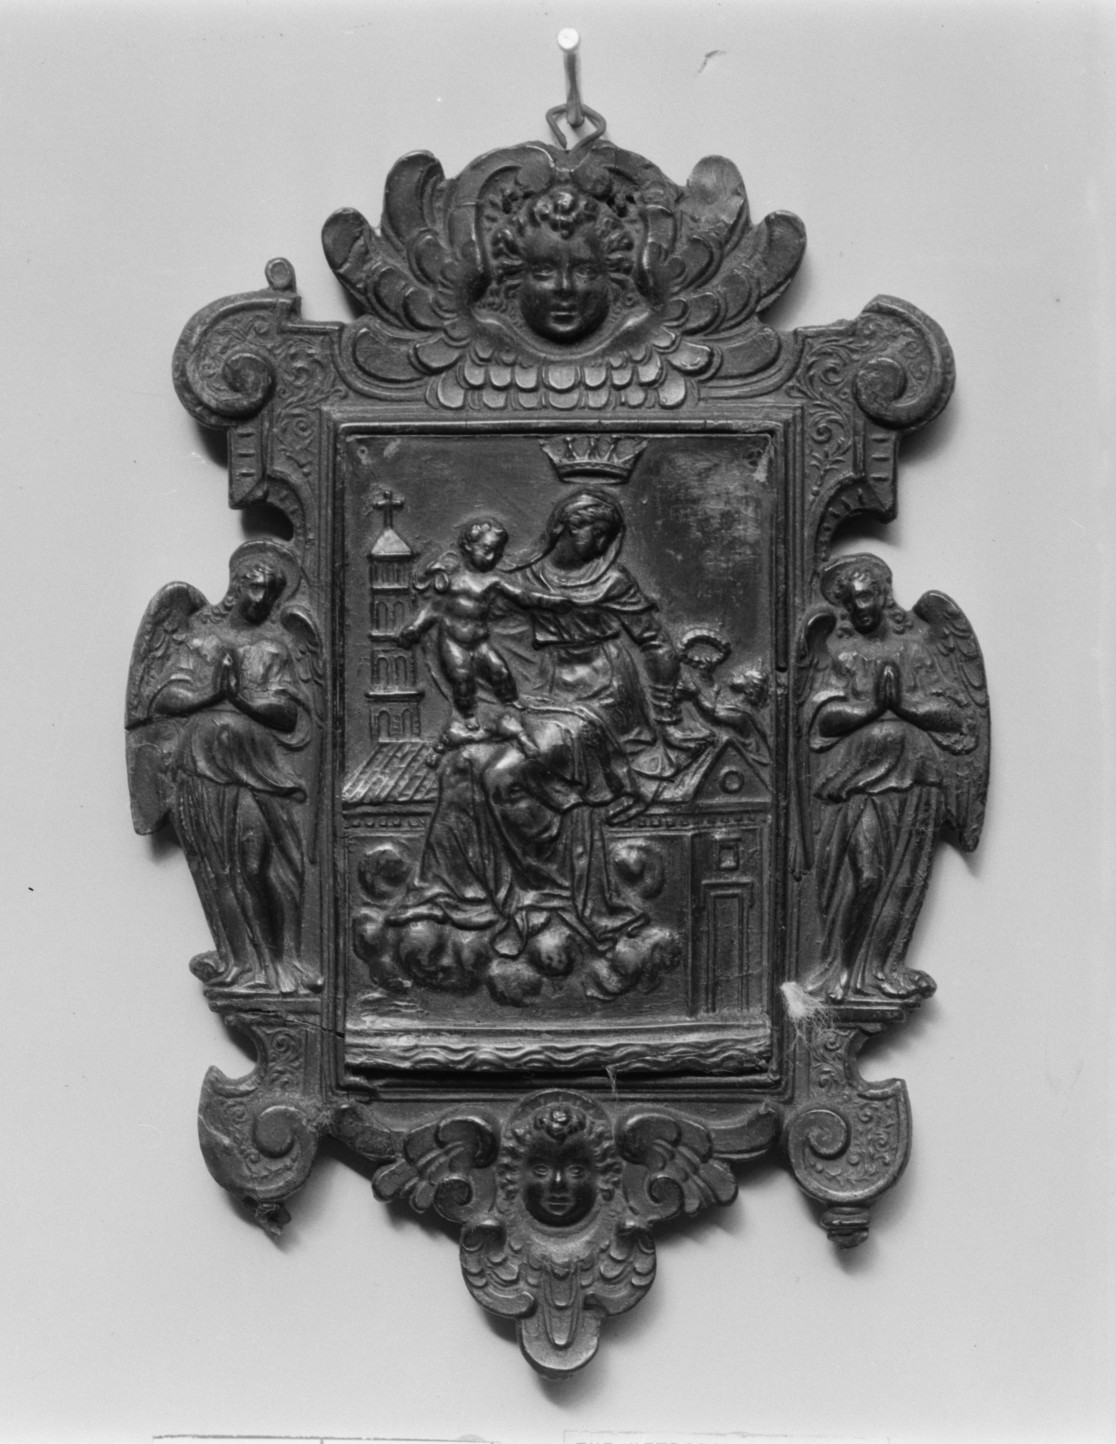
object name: plaquette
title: The Madonna of Loreto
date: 1601-1633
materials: horn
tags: faces,angels,madonna and child,cross